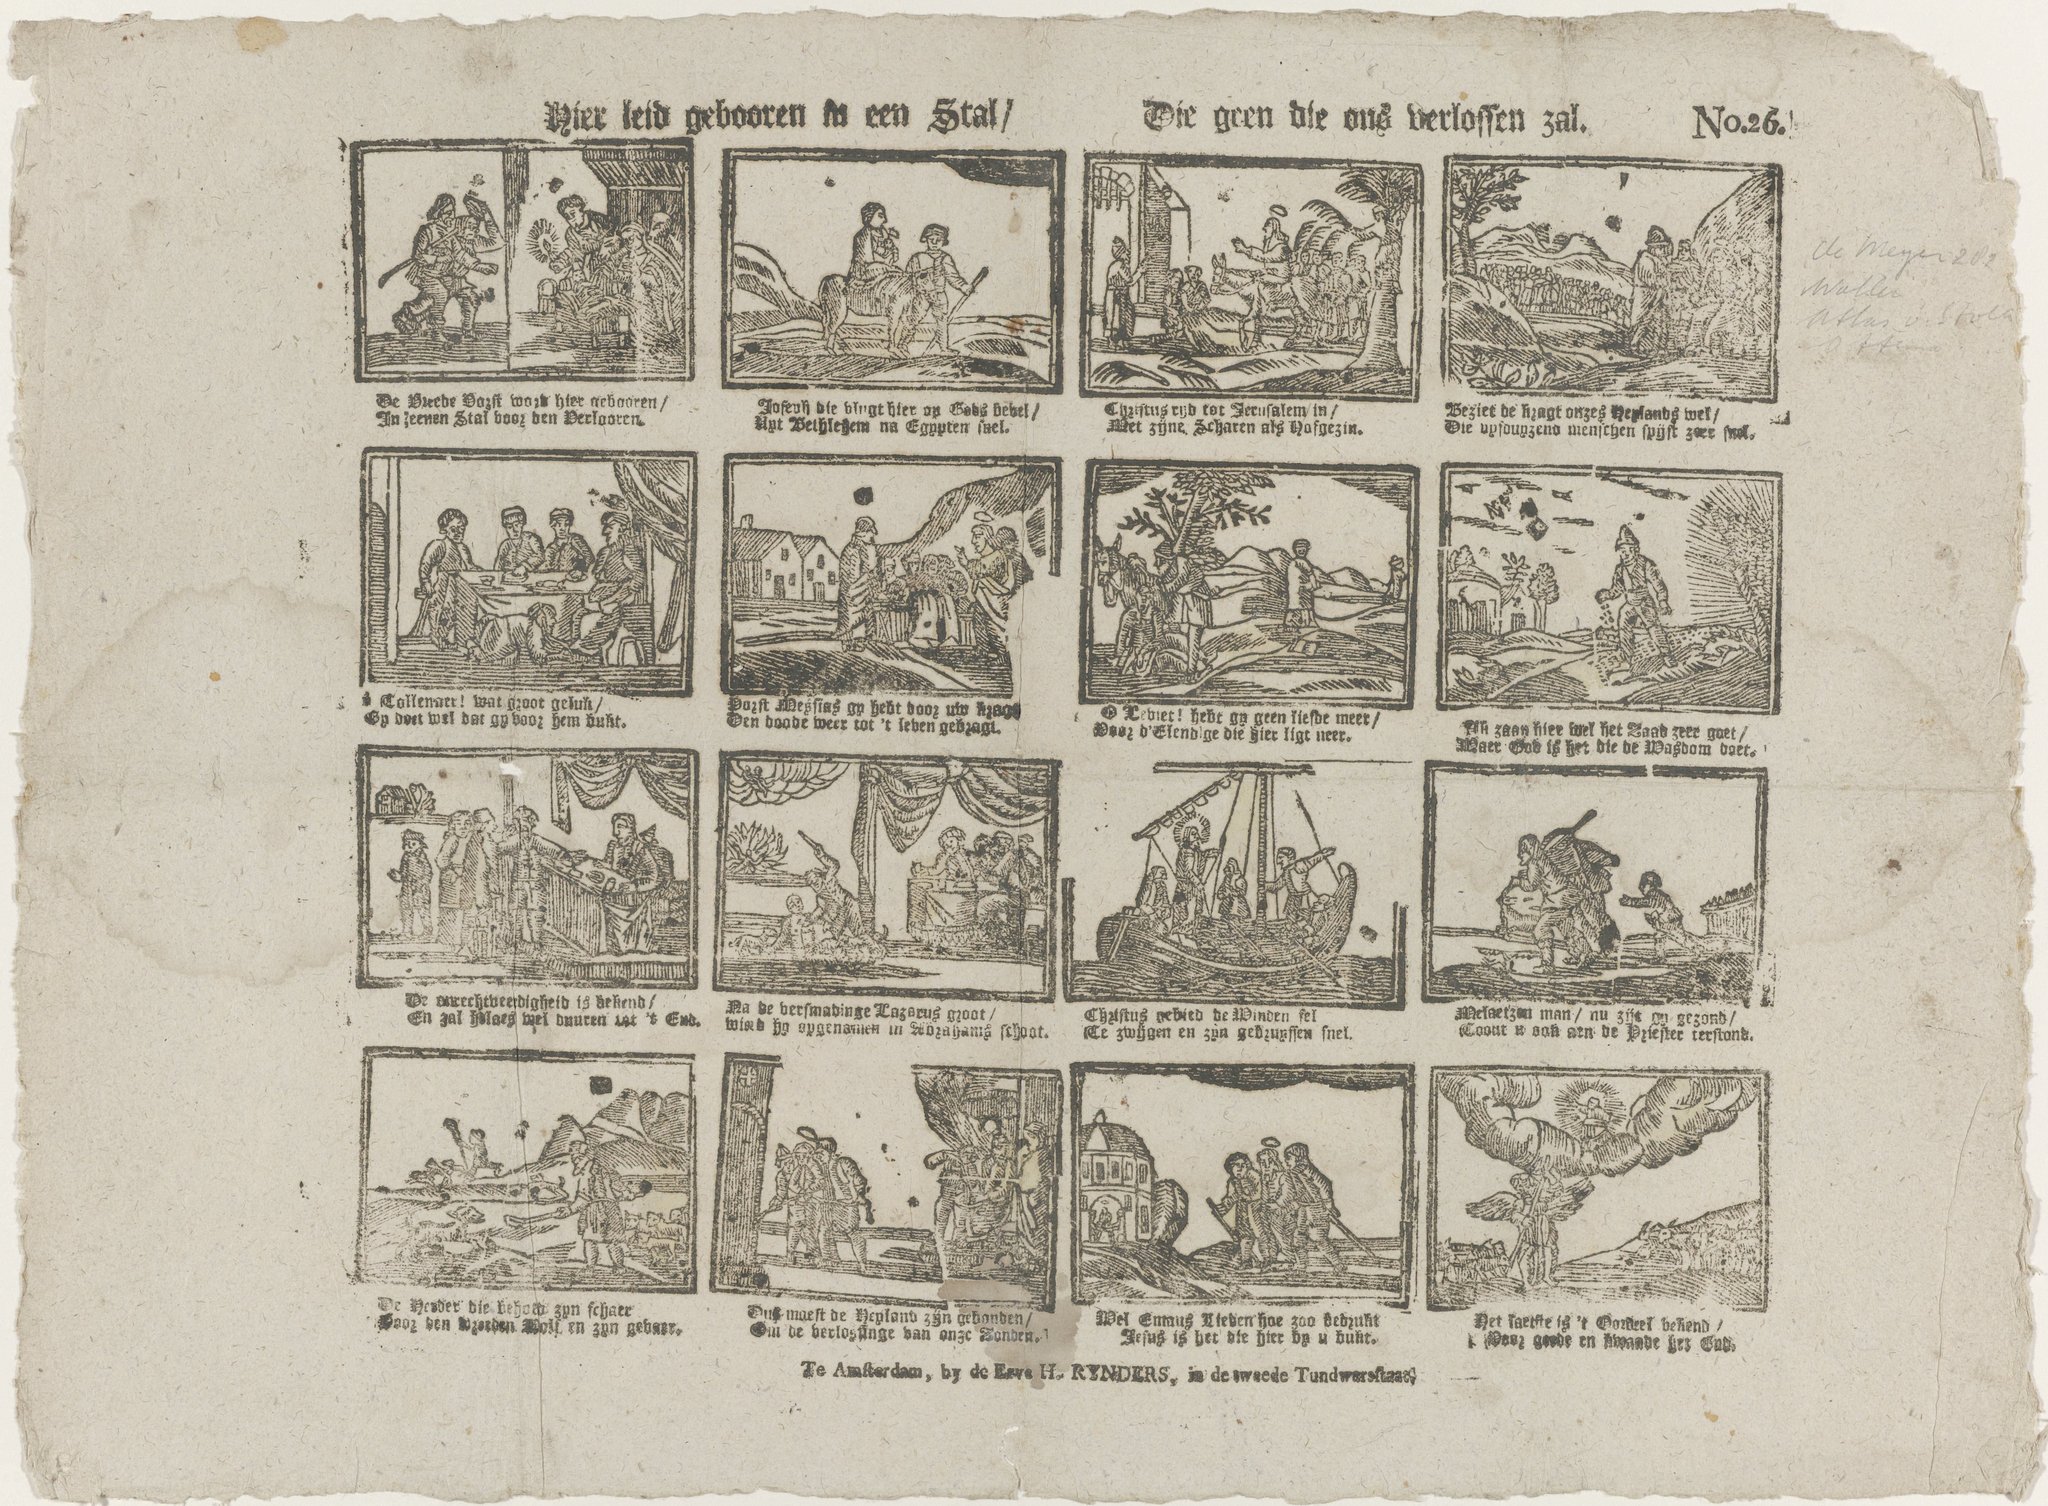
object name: print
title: Hier leid gebooren in een stal / Die geen die ons verlossen zal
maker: Anonymous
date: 1831-1854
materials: paper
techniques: letterpress printing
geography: amsterdam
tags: new testament, series of scenes from the life of christ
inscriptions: collector's mark: Lugt 2760, collector's mark: Lugt 2228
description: Blad met 16 voorstellingen uit het leven van Christus, zoals de aanbidding door de herders en de vlucht naar Egypte. Onder elke afbeelding een tweeregelig vers. Genummerd rechtsboven: No. 26.